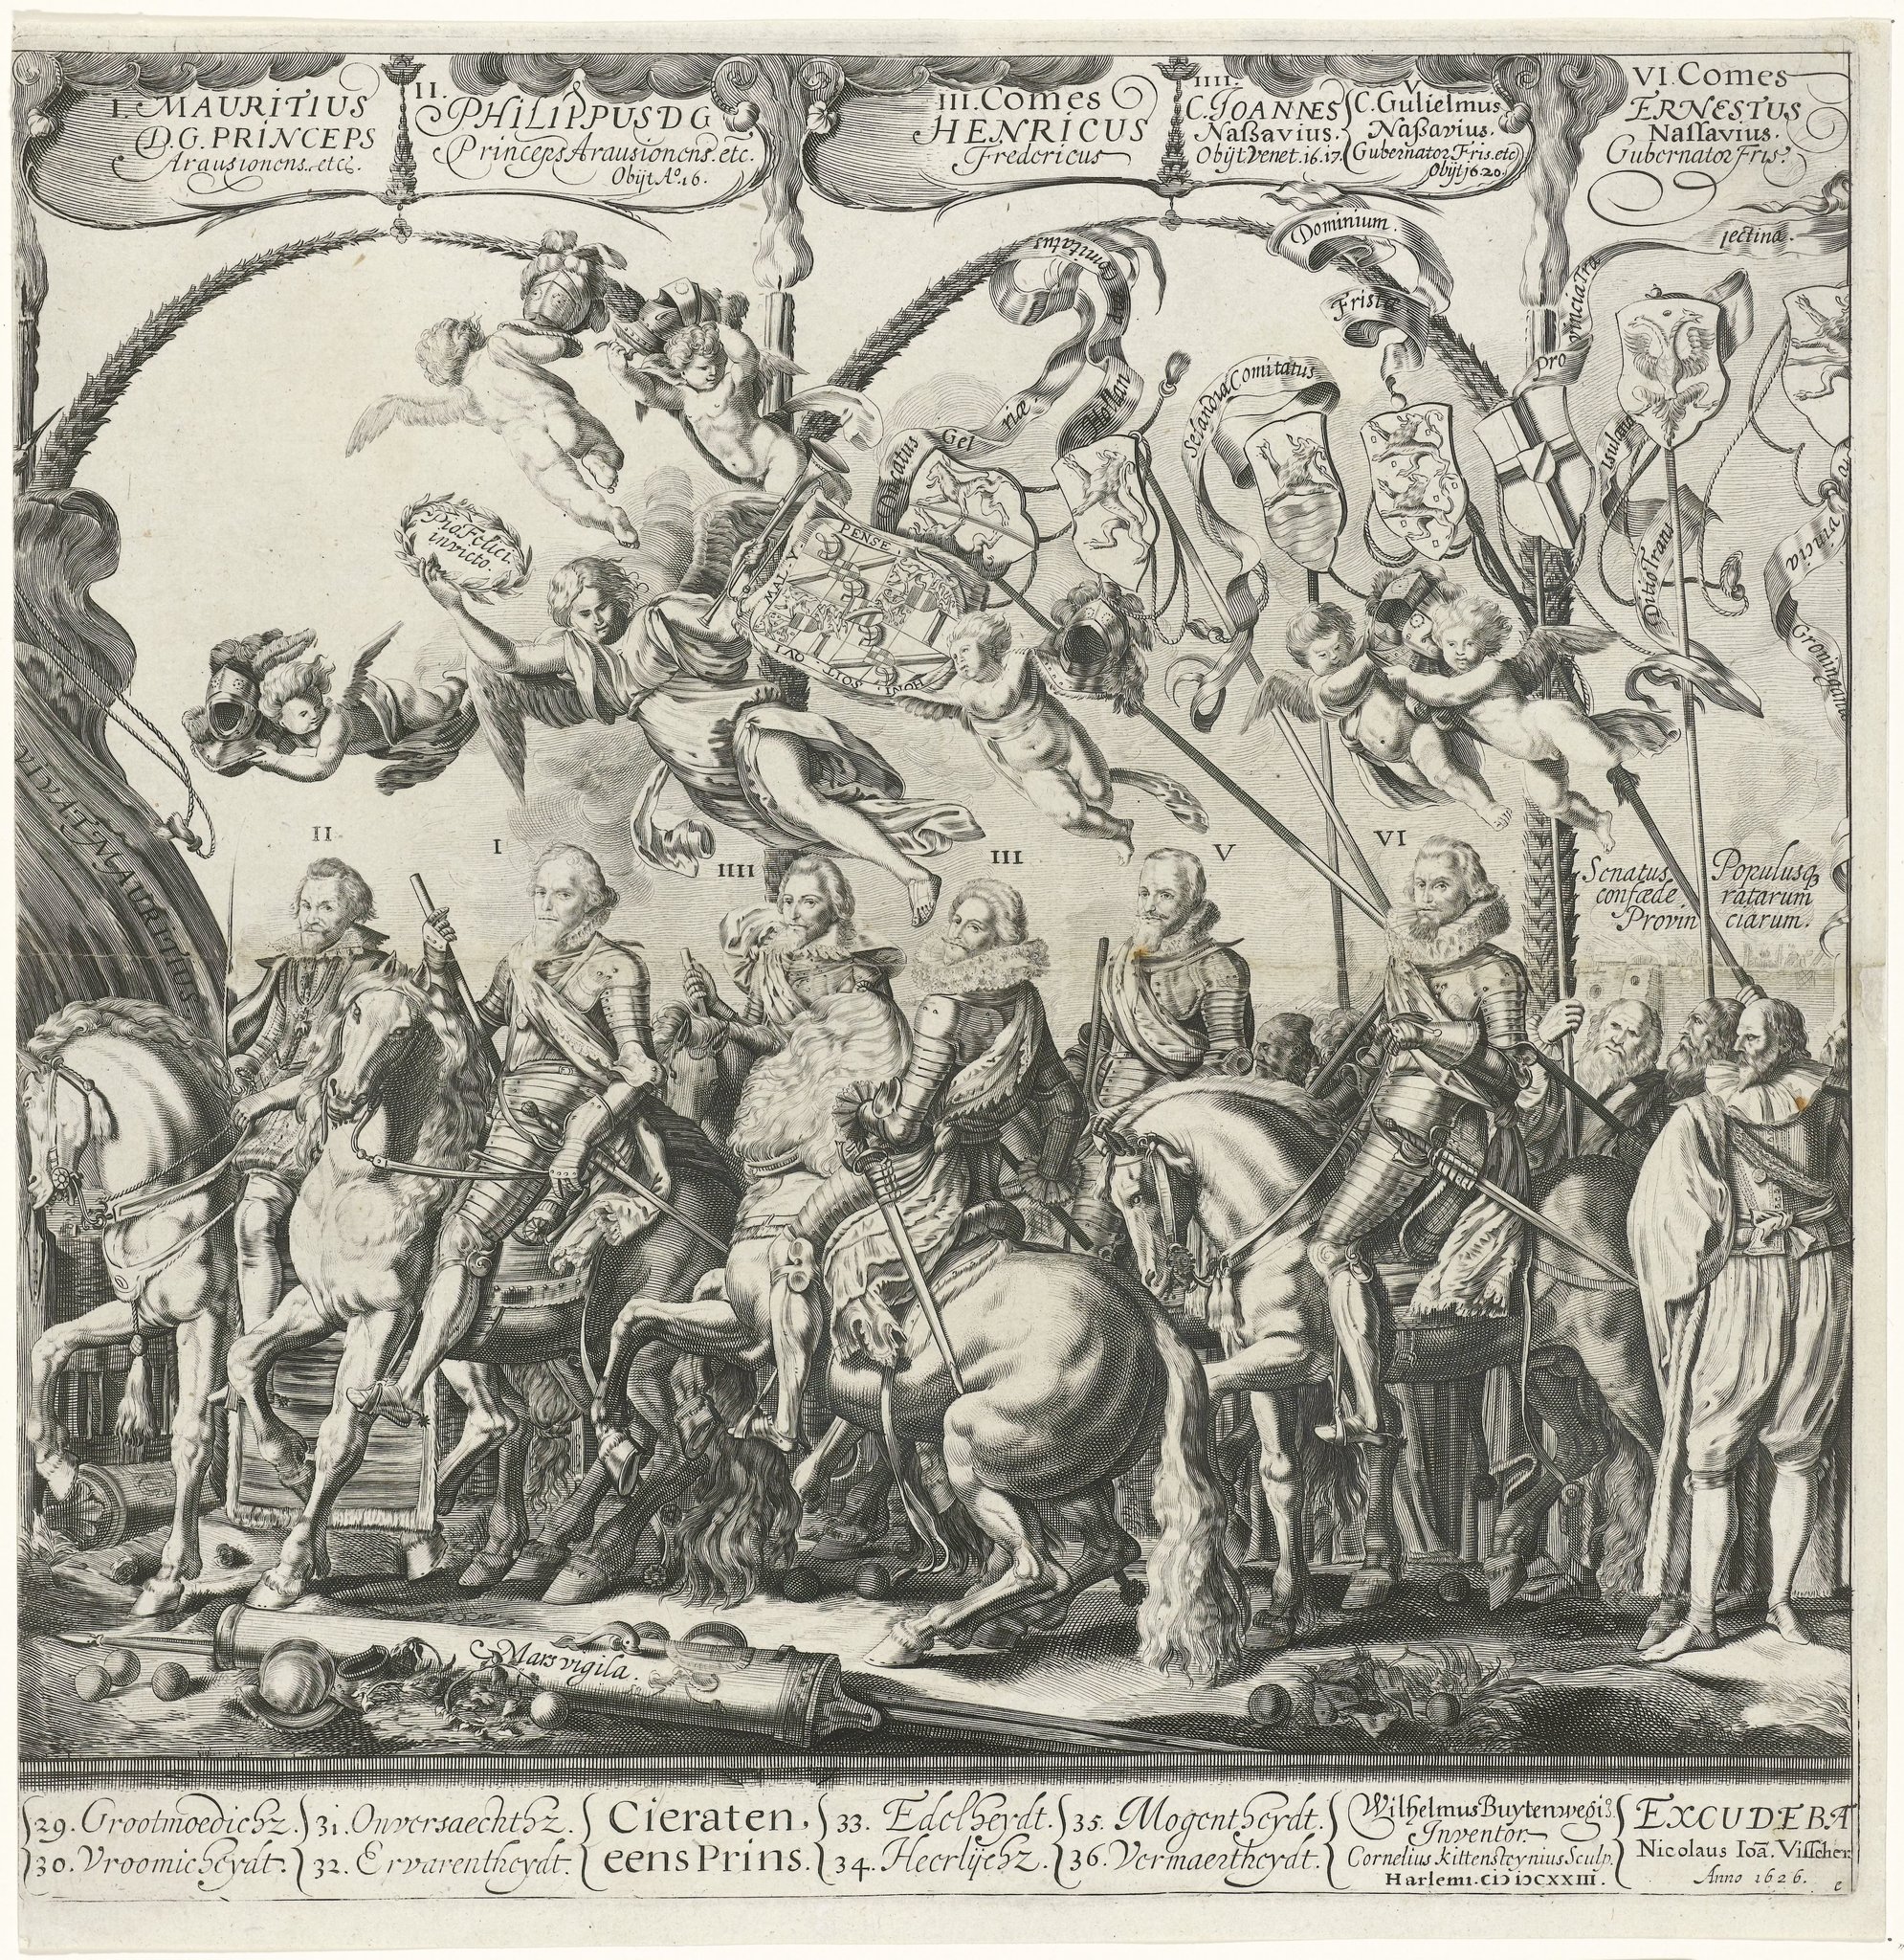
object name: propagandaprent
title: Triomftocht van Willem van Oranje, plaat e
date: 1623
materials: paper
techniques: engraving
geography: haarlem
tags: delft, frederick henry (prince of orange), william i (prince of orange), maurice (prince of orange), willem lodewijk graaf van nassau-dillenburg, filips willem (prins van oranje), ernst casimir graaf van nassau-dietz, symbolic triumphs of individual persons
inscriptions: collector's mark: Lugt 240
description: Zinnebeeldige voorstelling van de deugden van Prins Willem van Oranje. Zegewagen waarin de prins zit, rijdt onder een erepoort van loofwerk door, getrokken door 3 olifanten. Achter de wagen rijden prinsen van Oranje te paard. Met uitleg in het Latijn boven de figuren, Hollandse vertaling onderaan.